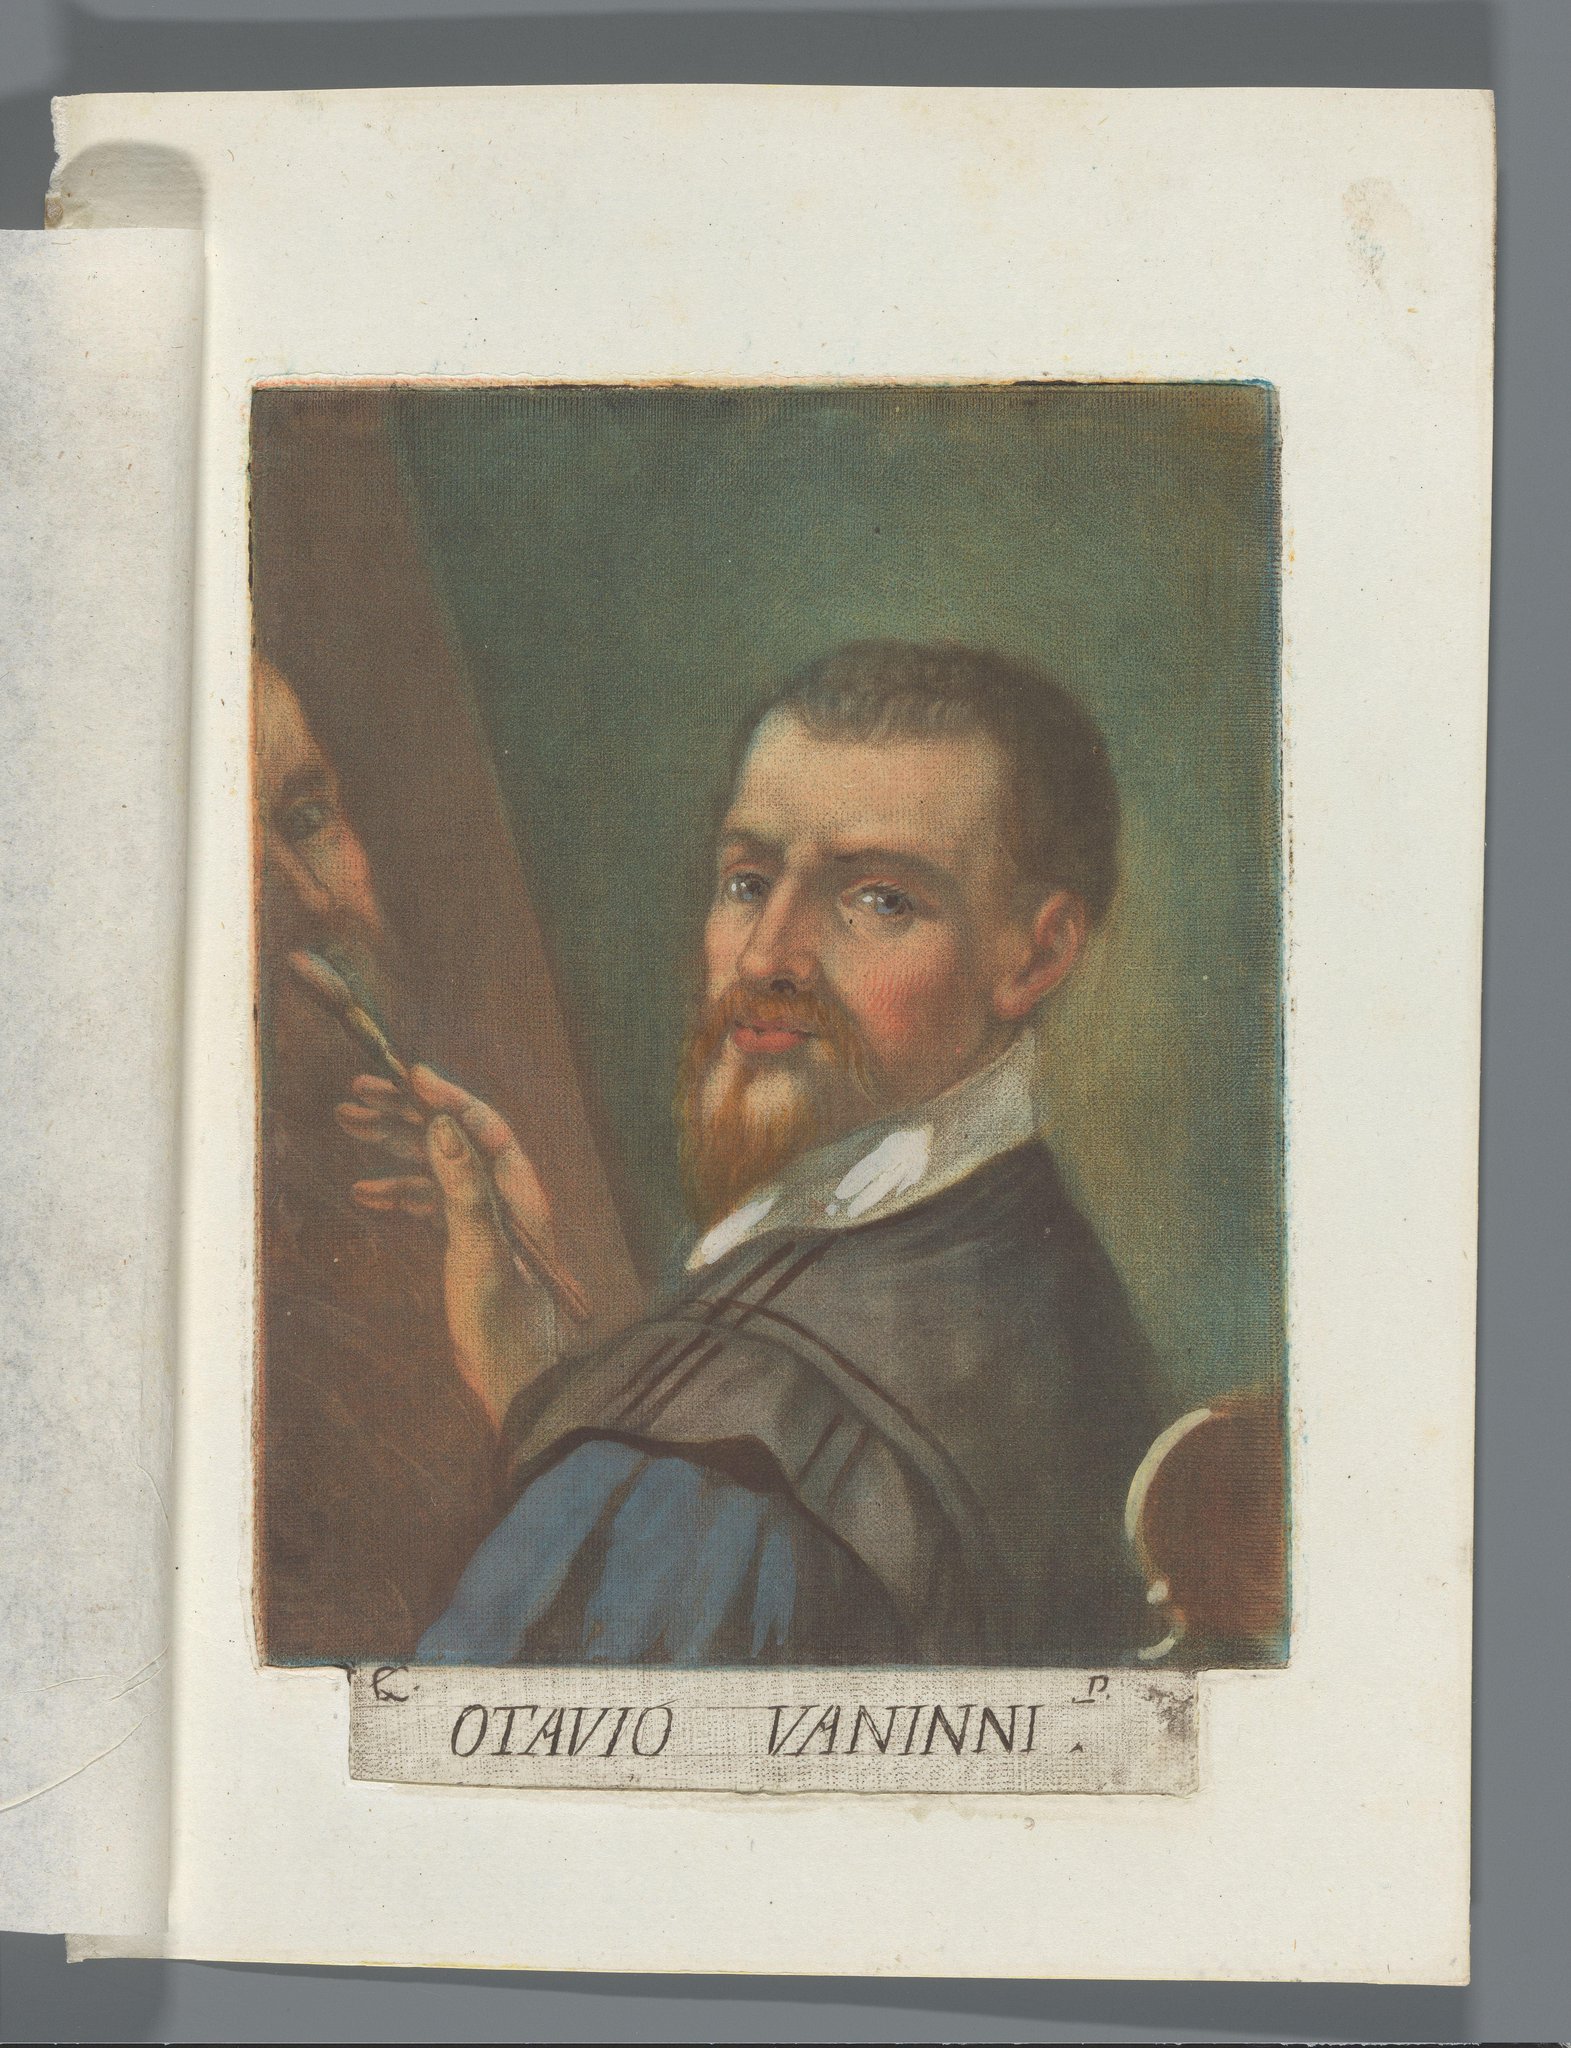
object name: print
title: Portret van Ottavio Vannini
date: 1789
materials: gouache, paper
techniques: color mezzotint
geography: florence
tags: draughtsman, ottavio vannini, historical persons, portrait, self-portrait of painter, portrait, self-portrait of artist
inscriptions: inscription:, collector's mark: Lugt 2228, number: ‘35’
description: Een prent uit een groep van veertig kleurendrukken met kunstenaarsportretten, gebaseerd op de collectie geschilderde zelfportretten van kunstenaars verzameld door de Medici in Florence. De groep maakt deel uit van het grote werk van Lasinio ‘Gli Autoritratti della Real Galleria di Firenze’, uitgegeven in 1789 met omstreeks 350 kunstenaarsportretten. Van deze uitgave is tot nog toe is geen compleet exemplaar bekend. In de inspringende marges onderaan de prenten zijn de namen van de kunstenaars aangebracht en soms hun levensdata en de plaats van geboorte en sterven en een enkele maal de signatuur van Lasinio en dat van de drukker Labrelis. Getuige de bindgaatjes en lijmresten moeten de prenten ingebonden zijn geweest in een album. De meeste prenten zijn verso voorzien van nummers in potlood, met als laagste nummer 2 en hoogste 93. Tevens zijn er verso Italiaanse opschriften in pen aangebracht met de levensdata van de kunstenaars en de school waartoe zij worden gerekend. Deze opschriften zijn vrijwel alle deels afgesneden. Elf prenten zijn niet genummerd en niet voorzien van opschriften. Deze laatste elf zijn alle gedrukt op blauw papier.